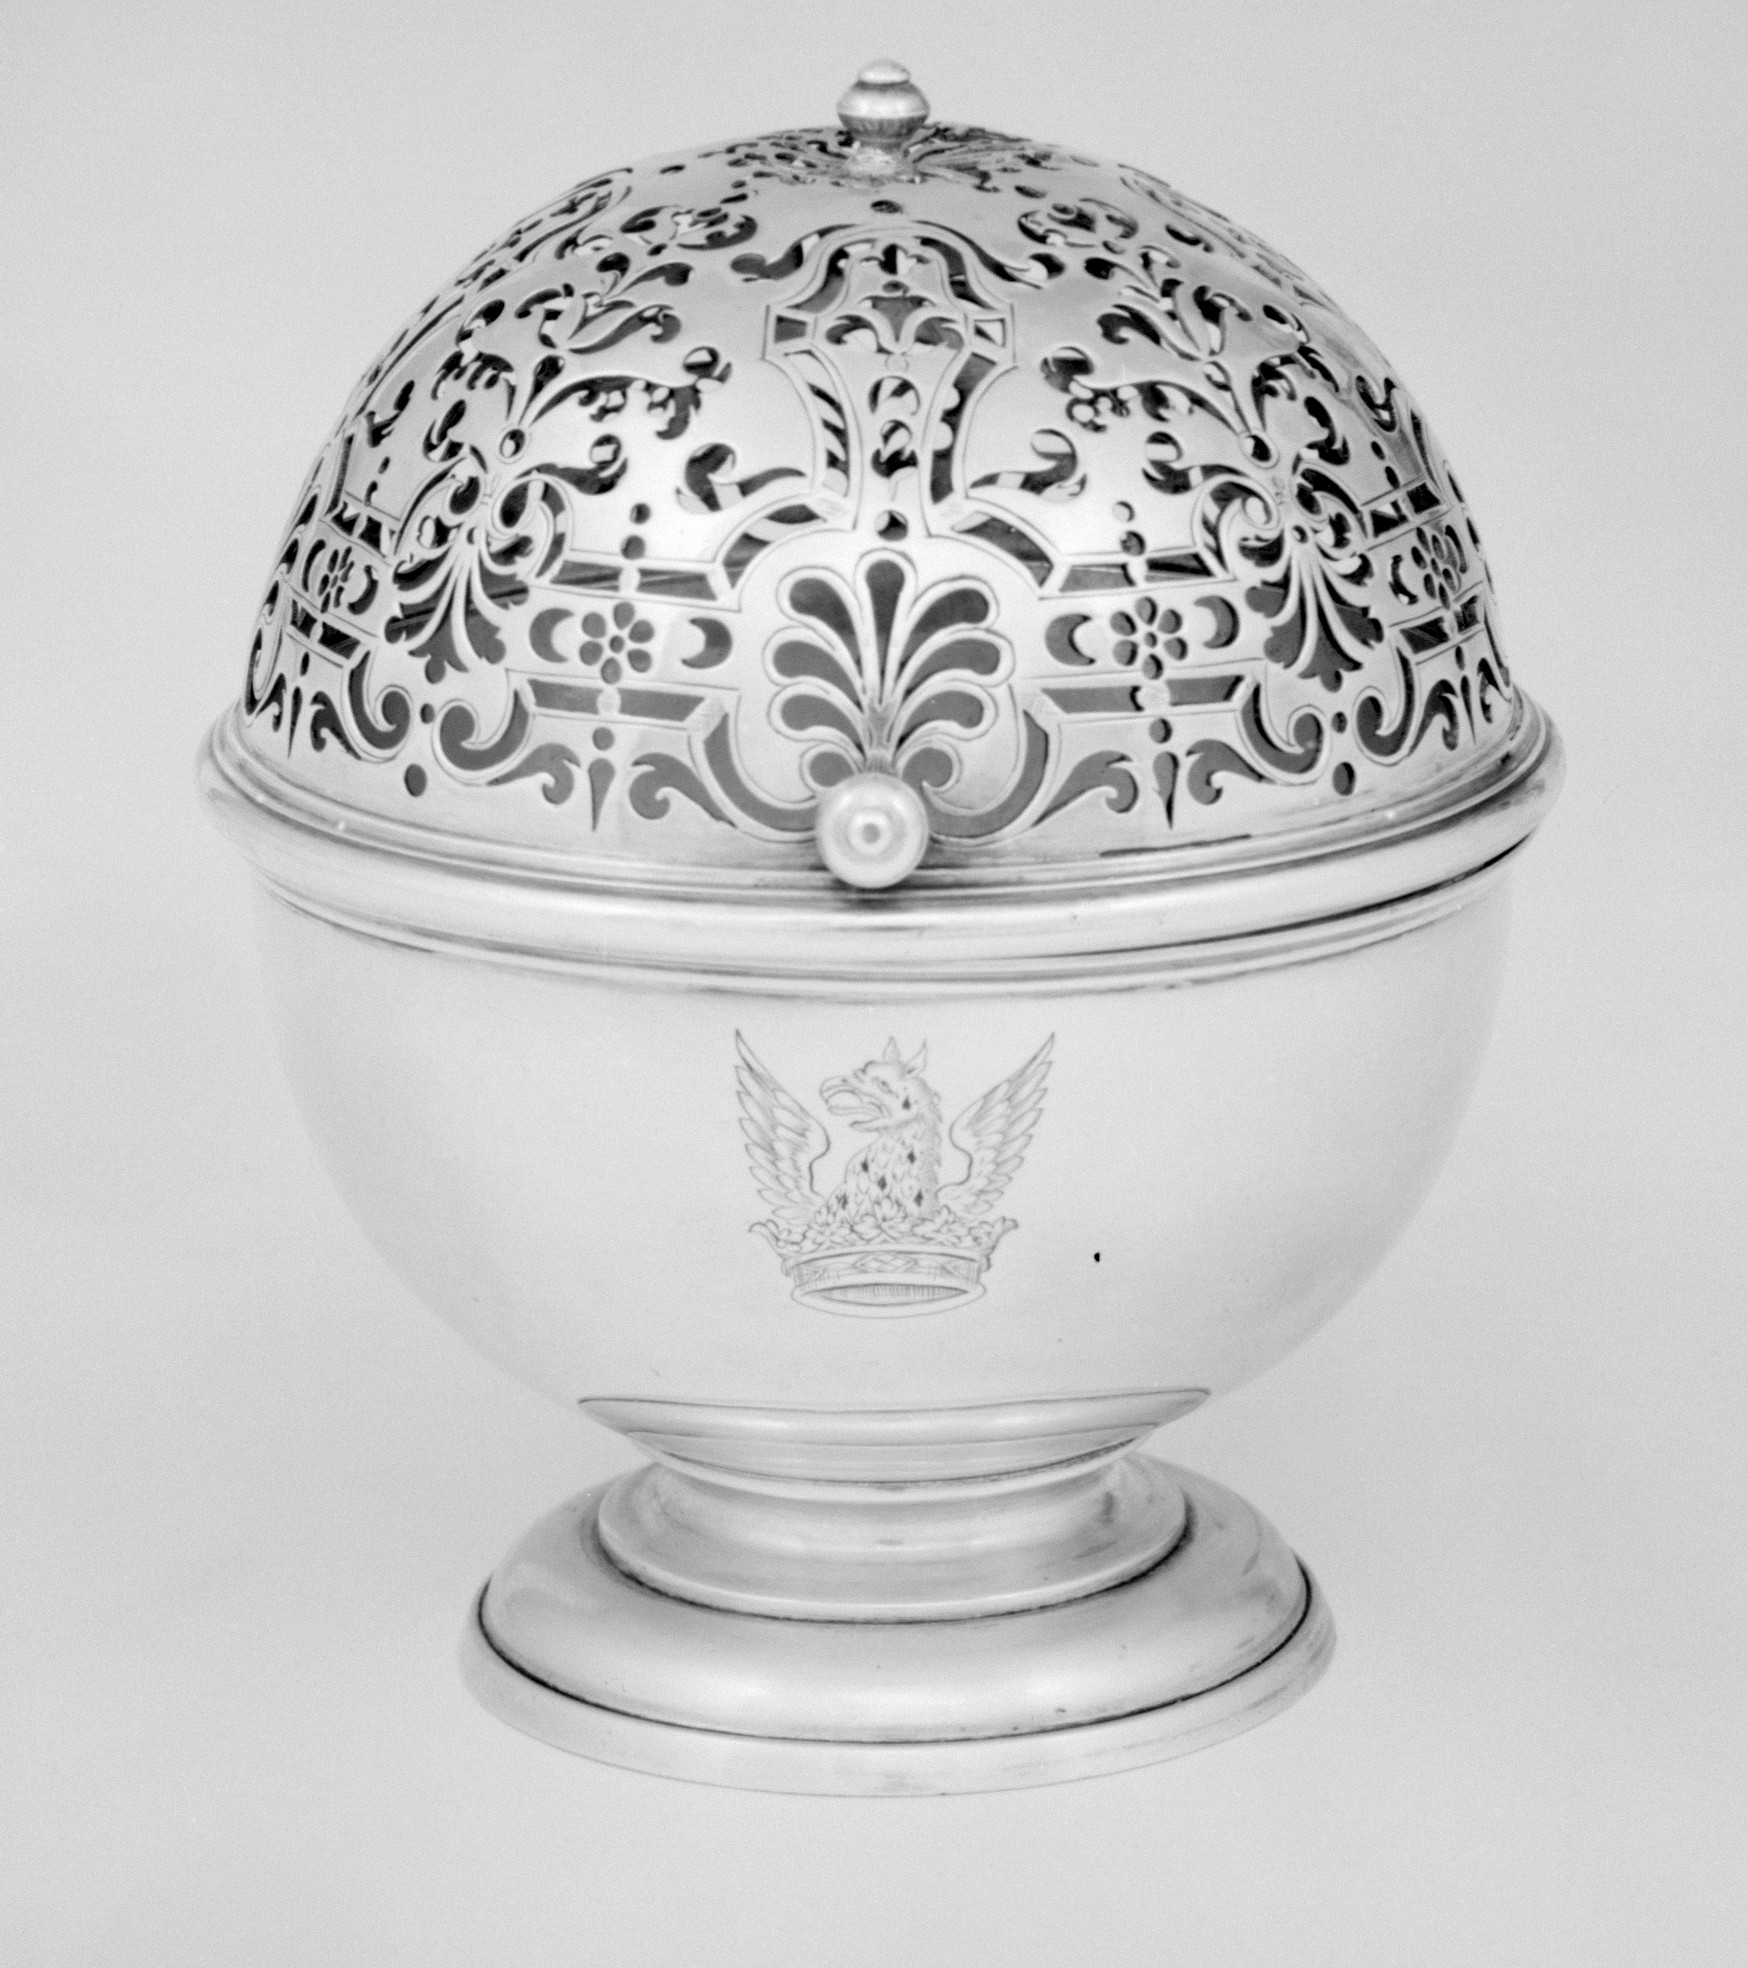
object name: soap box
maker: anthony nelme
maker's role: maker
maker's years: 1622-1722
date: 1713-1714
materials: silver